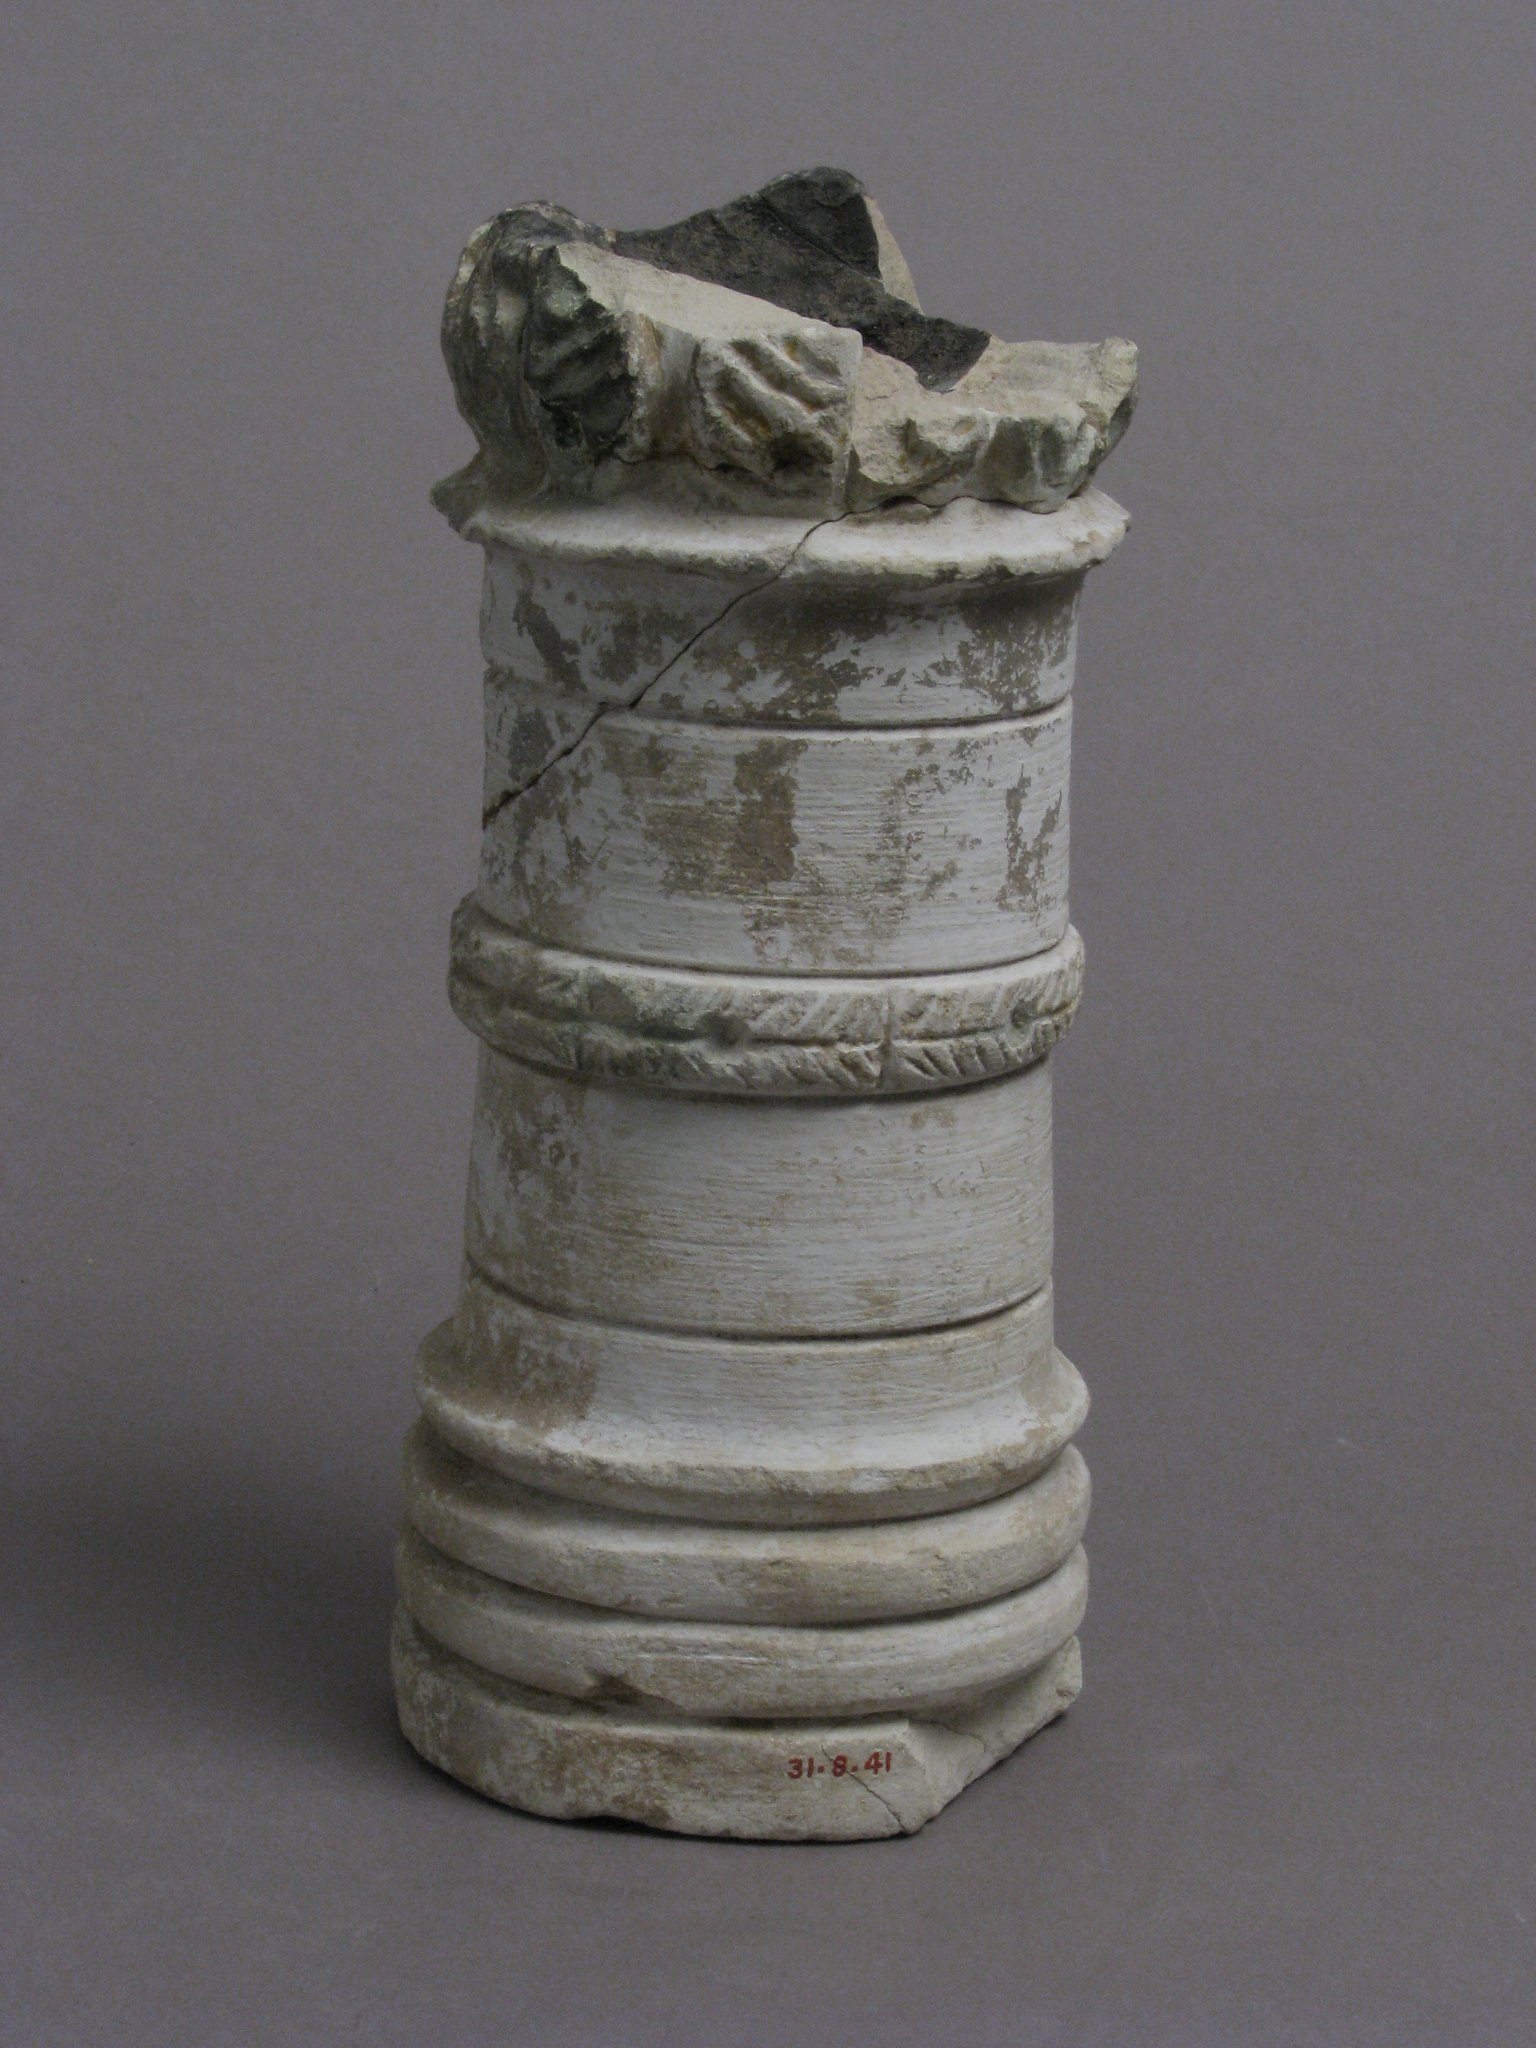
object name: altar or incense burner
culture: coptic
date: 301-700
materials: limestone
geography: egypt